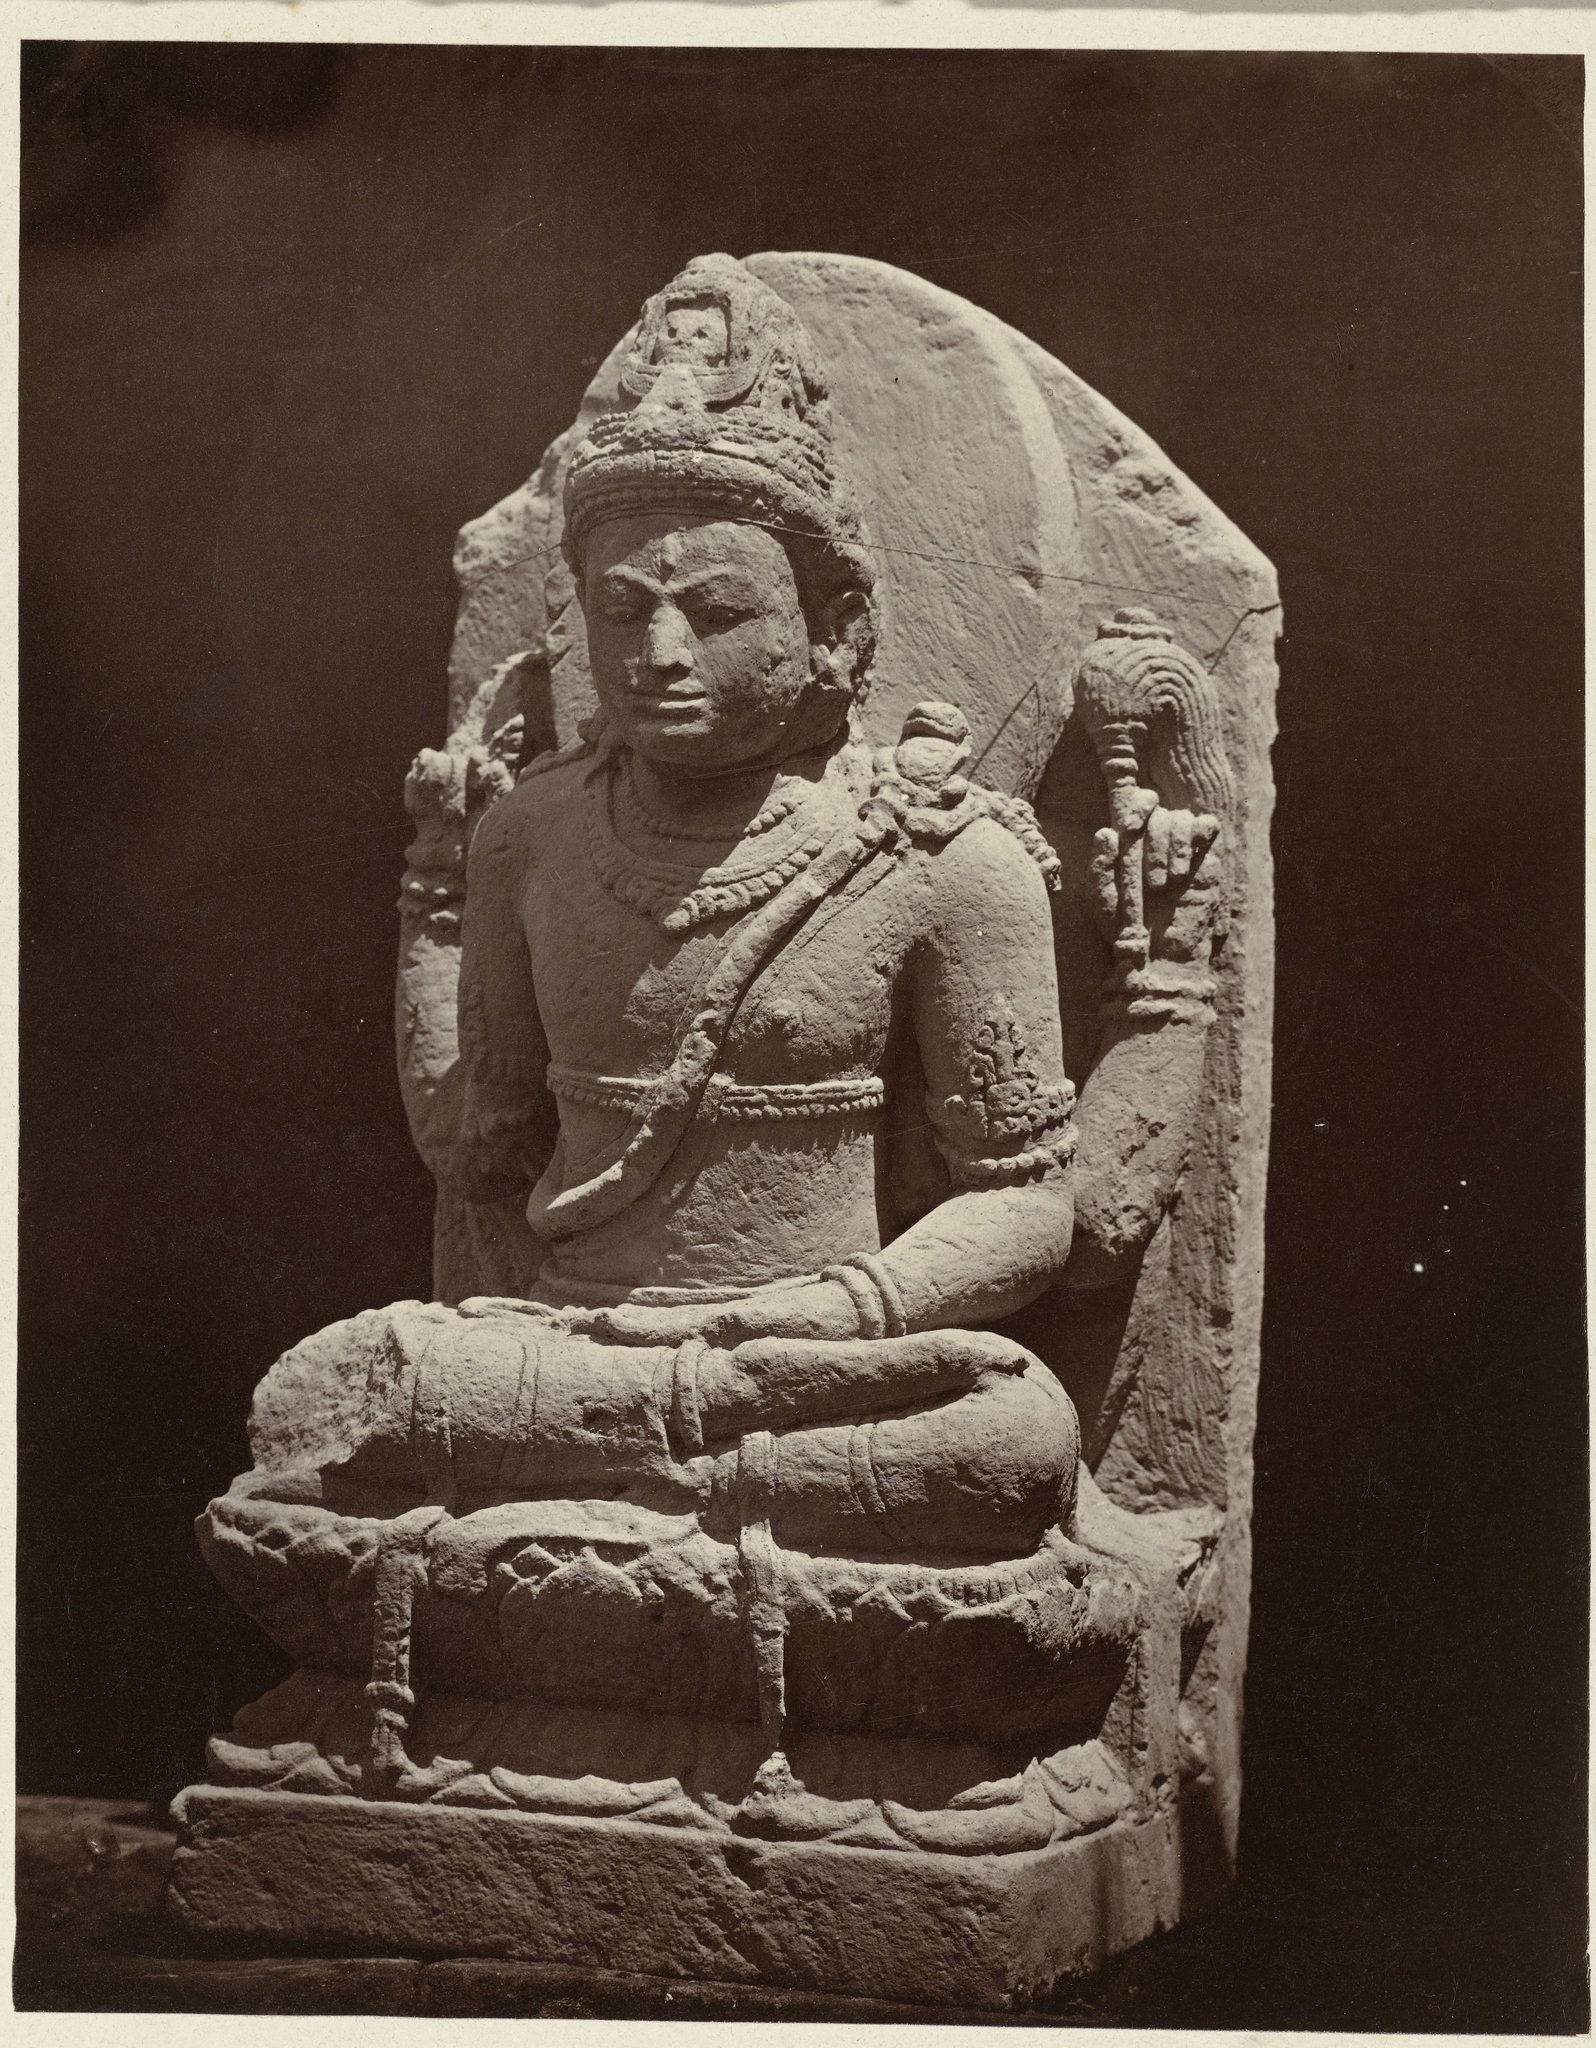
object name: photograph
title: Four armed Shiva of which one arm, probably displaying the varada mudra, has broken off. Dieng Plateau, Wonosobo district, Central Java province, 9th century.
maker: isidore kinsbergen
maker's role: fotograaf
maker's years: 1821-1905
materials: cardboard, paper, photographic support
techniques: albumen print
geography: java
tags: shiva